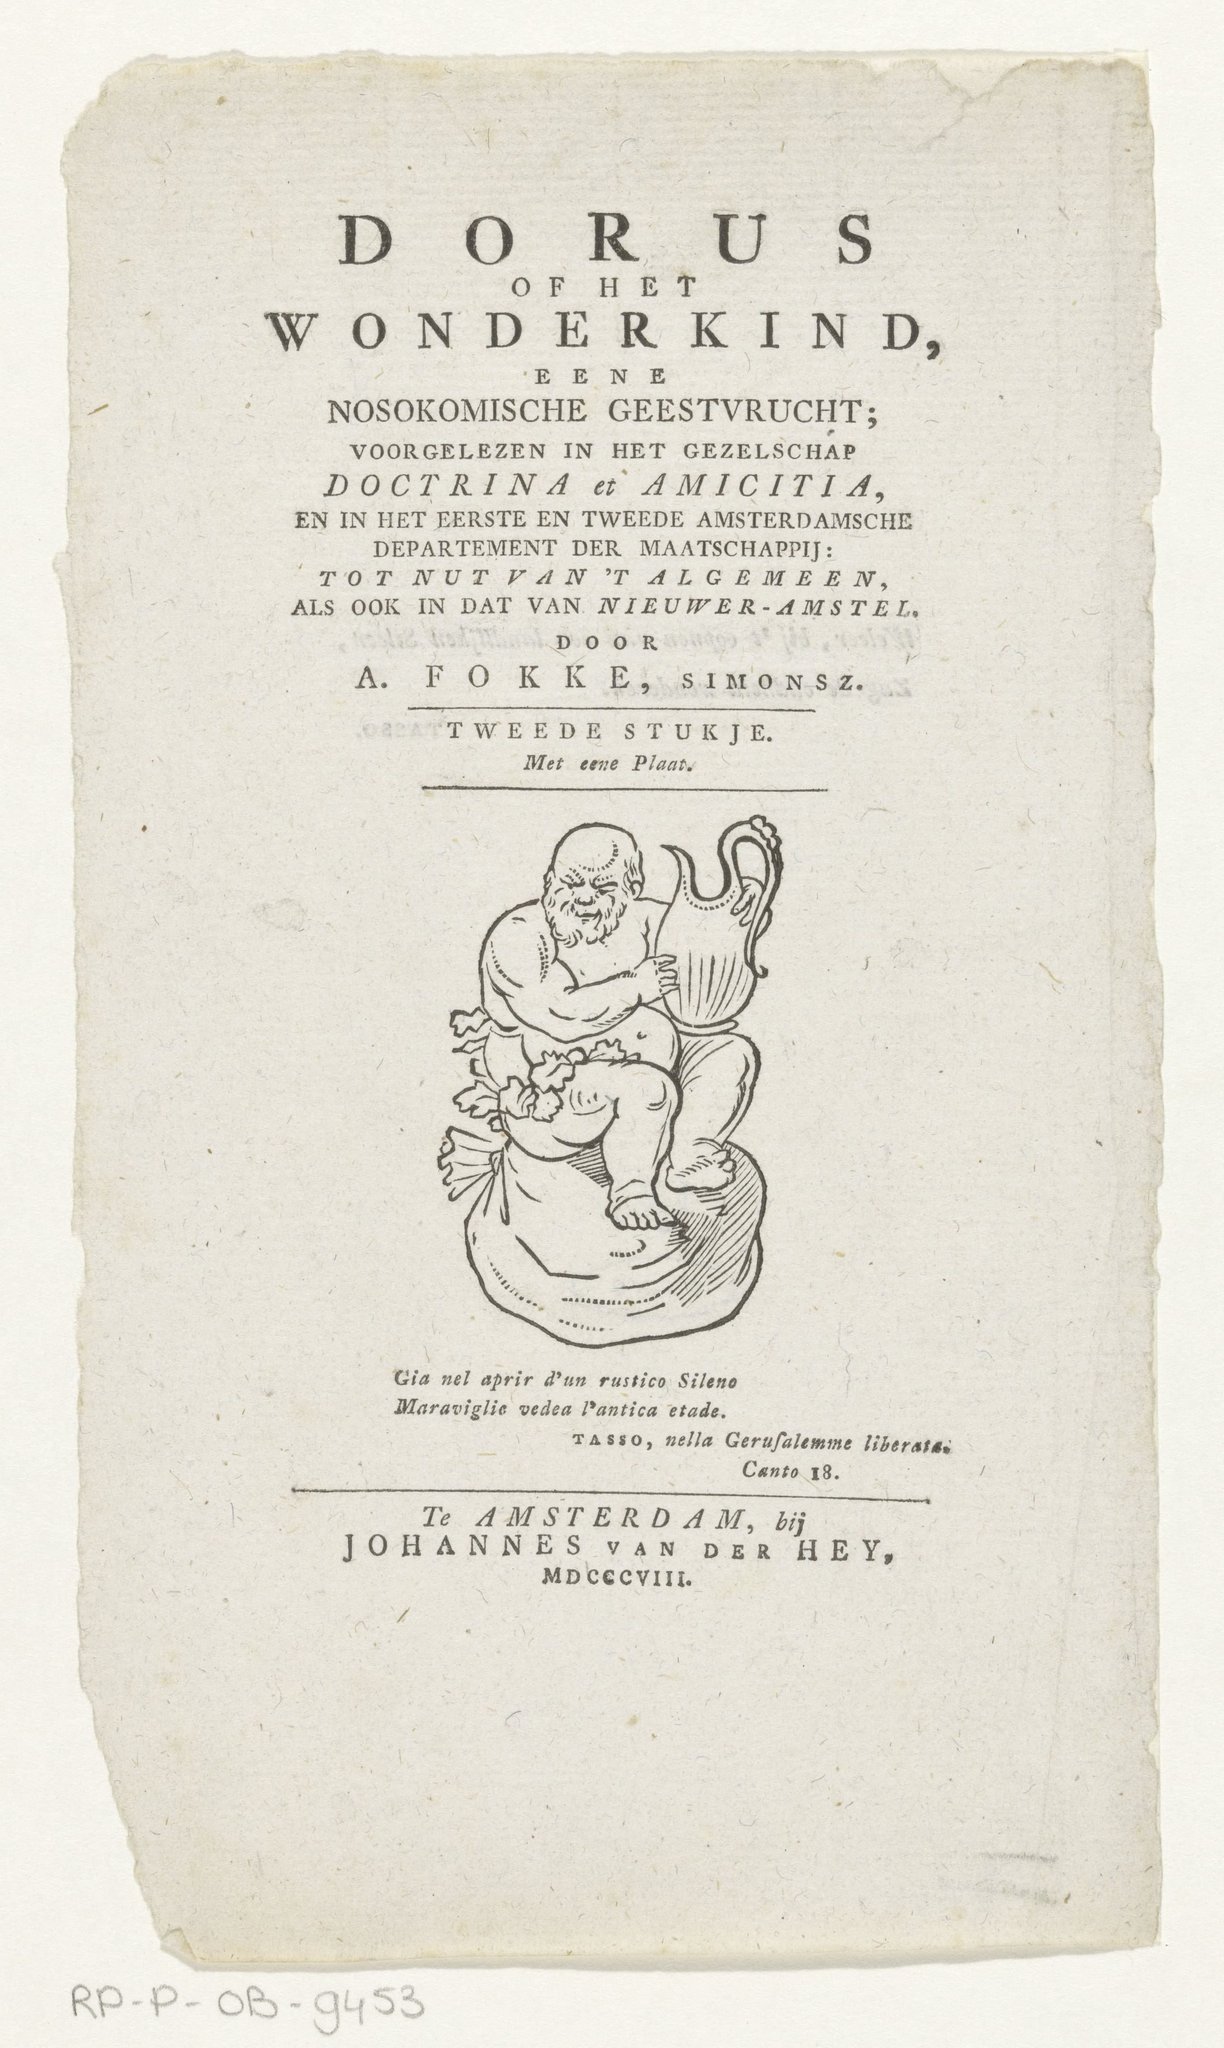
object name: titelblad, titelpagina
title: Titelpagina voor: Arend Fokke Simonsz, Dorus of het wonderkind, 1808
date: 1808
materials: paper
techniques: letterpress printing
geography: amsterdam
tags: jar, jug (used as drinking-vessel), old man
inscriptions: collector's mark: Lugt 2760, collector's mark: Lugt 2228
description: Een oude bebaarde man met wijnkan zit op een zak. Daaronder een vers uit het gedicht Jeruzalem Verlost (Gerusalemme liberata) van dichter Torquato Tasso.